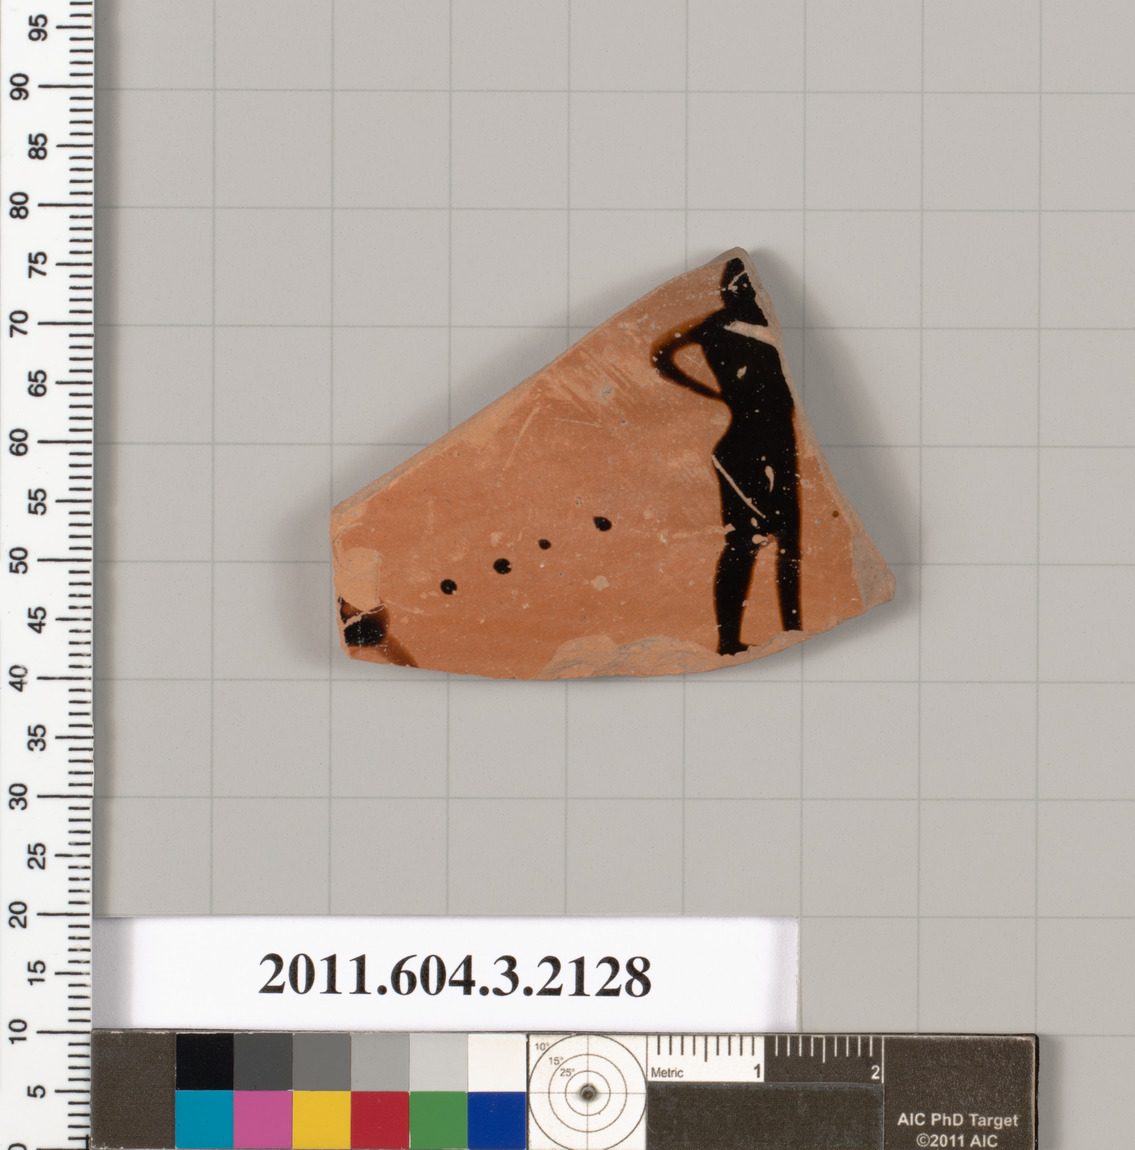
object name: kylix fragment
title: Terracotta fragment of a kylix (drinking cup)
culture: greek, attic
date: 500-468 BCE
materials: terracotta